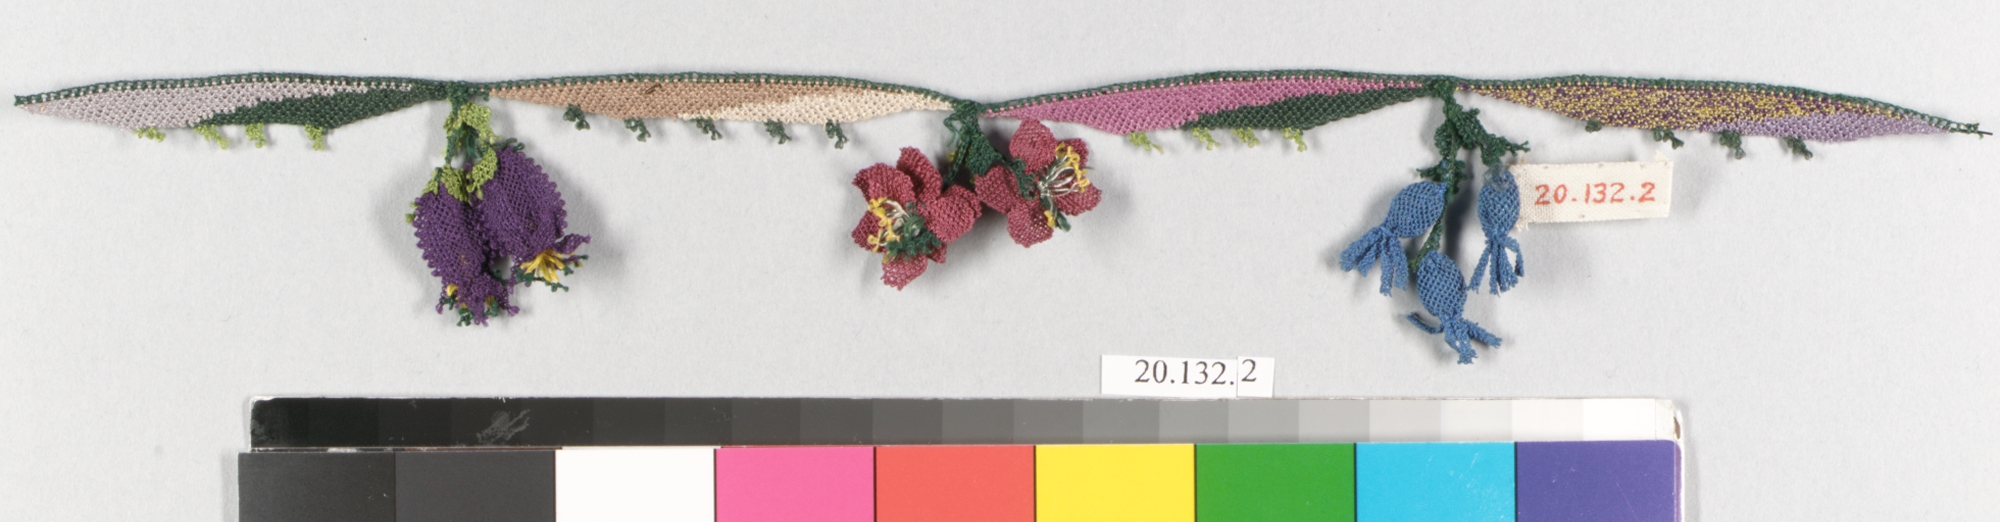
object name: oyah bibilia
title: Oyah (Bibilia)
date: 1801-1900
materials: silk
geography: turkey